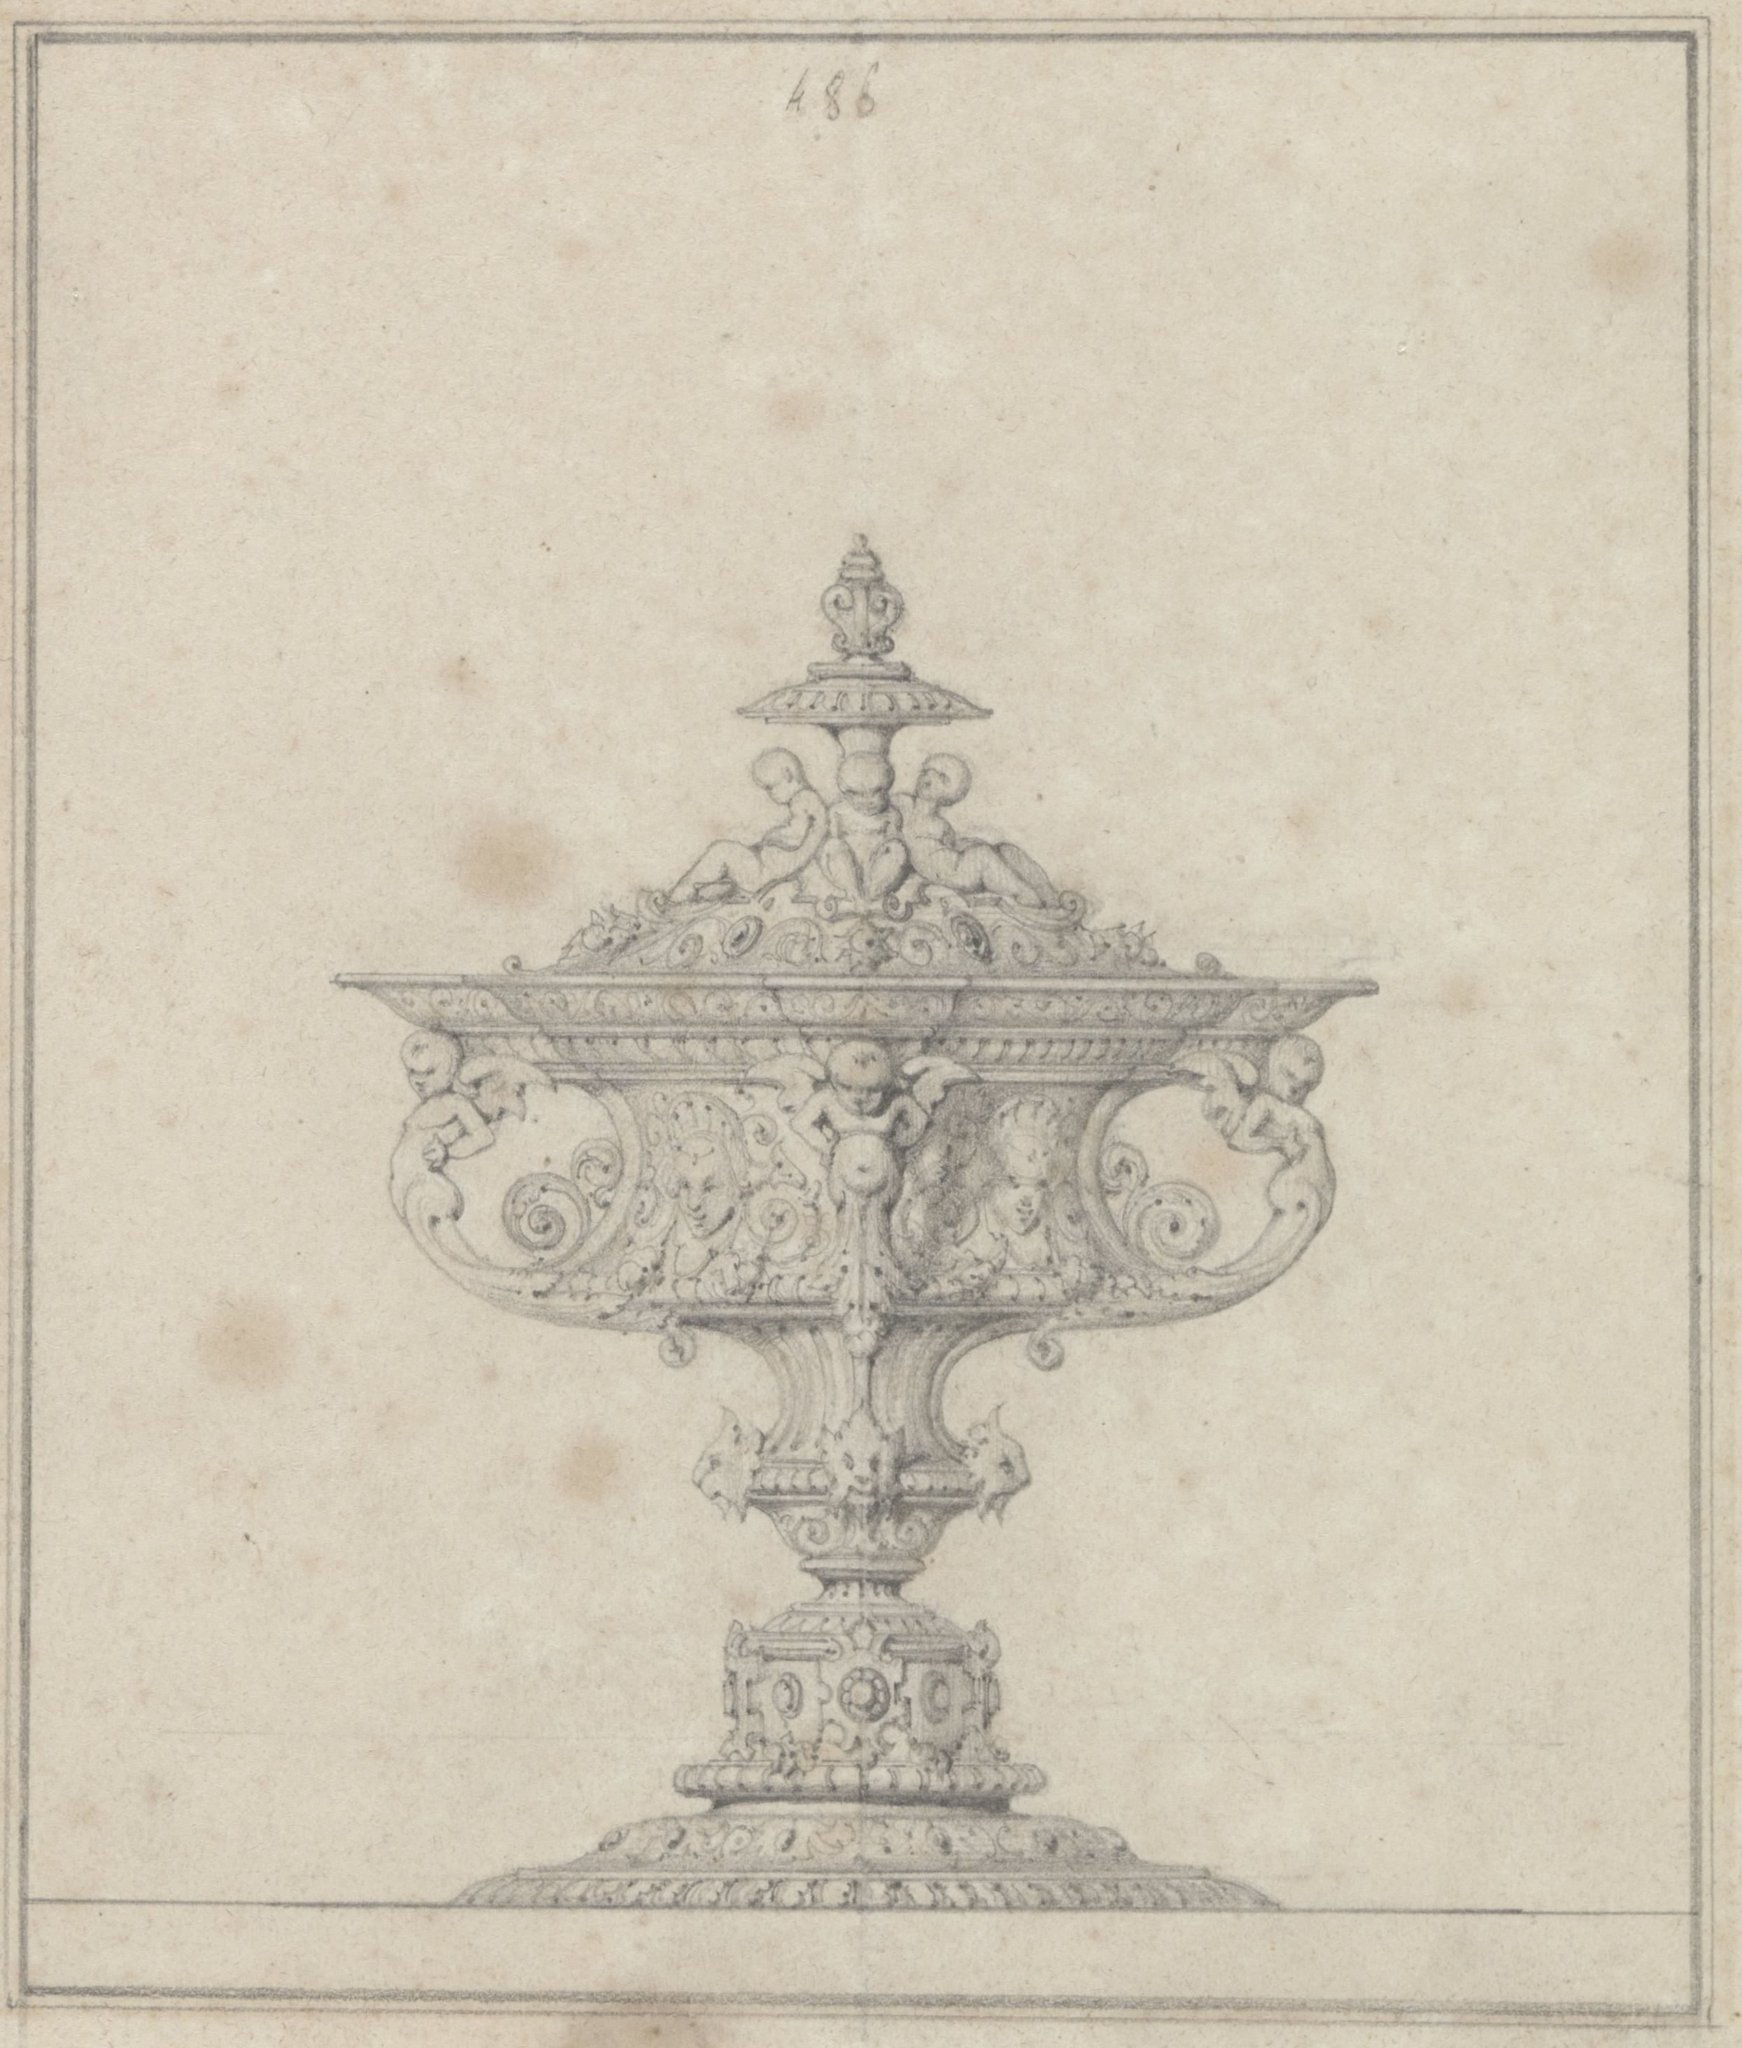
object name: design drawing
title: Ontwerp voor een coupe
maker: jean-jacques feuchère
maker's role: draughtsman, painter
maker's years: 1807-1852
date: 1830-1840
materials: graphite, paper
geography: france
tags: serving-dish, platter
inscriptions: inscription: ‘486’